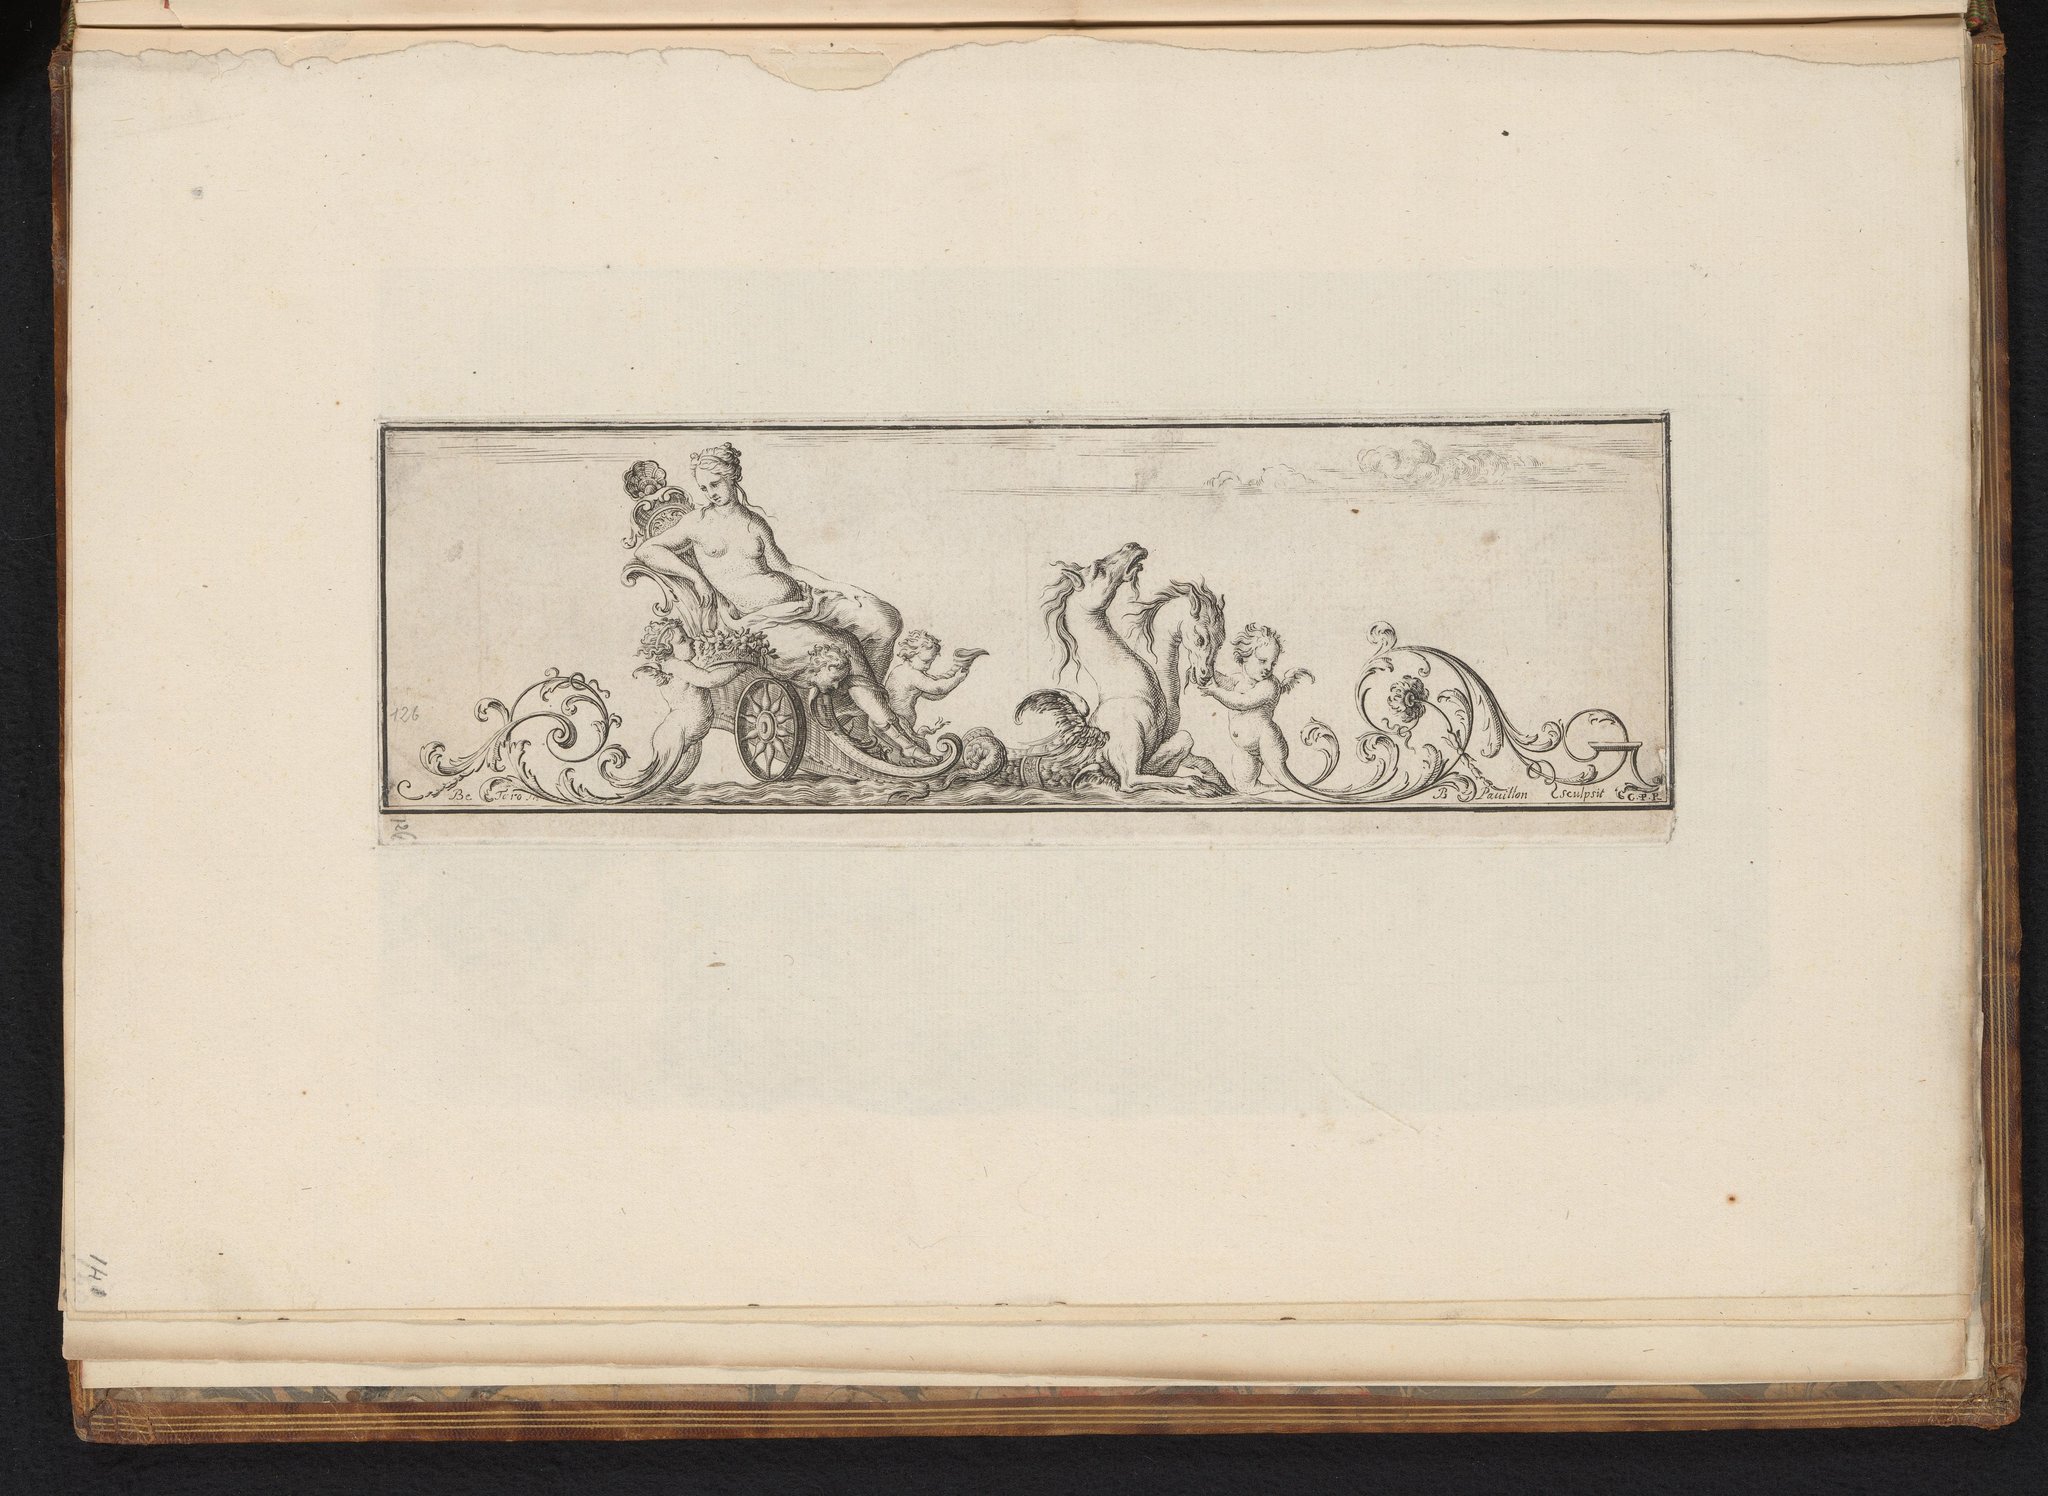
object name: print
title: Fries met Venus op triomfwagen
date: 1682-1729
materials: paper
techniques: engraving, etching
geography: france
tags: triumph of venus; 'carro di venere' (ripa)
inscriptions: collector's mark: Lugt 2228, collector's mark: Lugt 2760